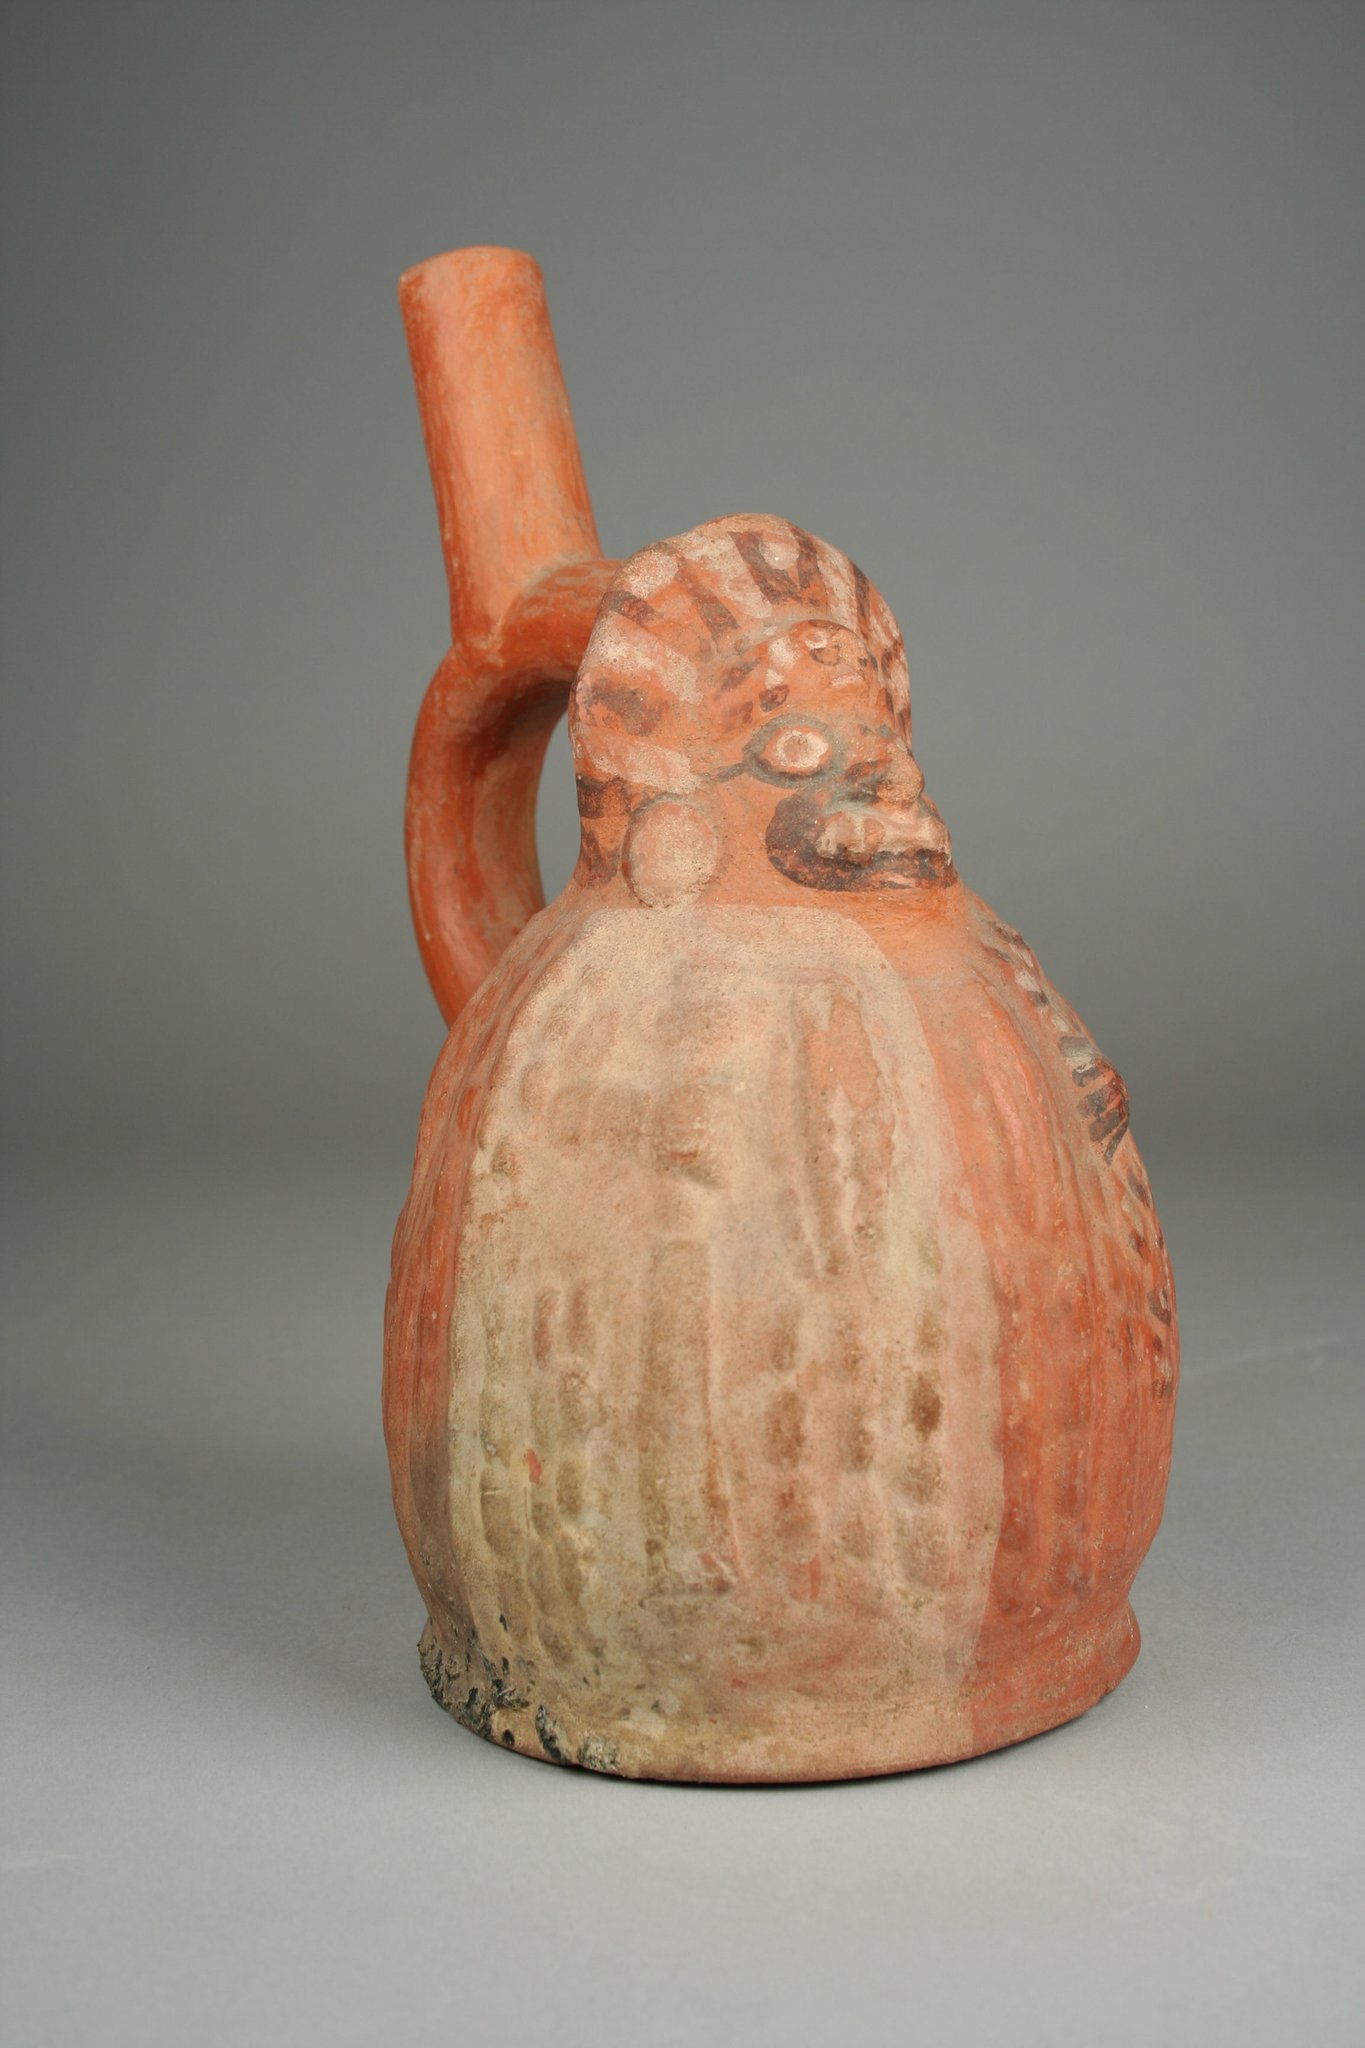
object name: bottle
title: Stirrup Spout Bottle with Ai-Apec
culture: moche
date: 401-700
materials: ceramic, pigment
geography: peru